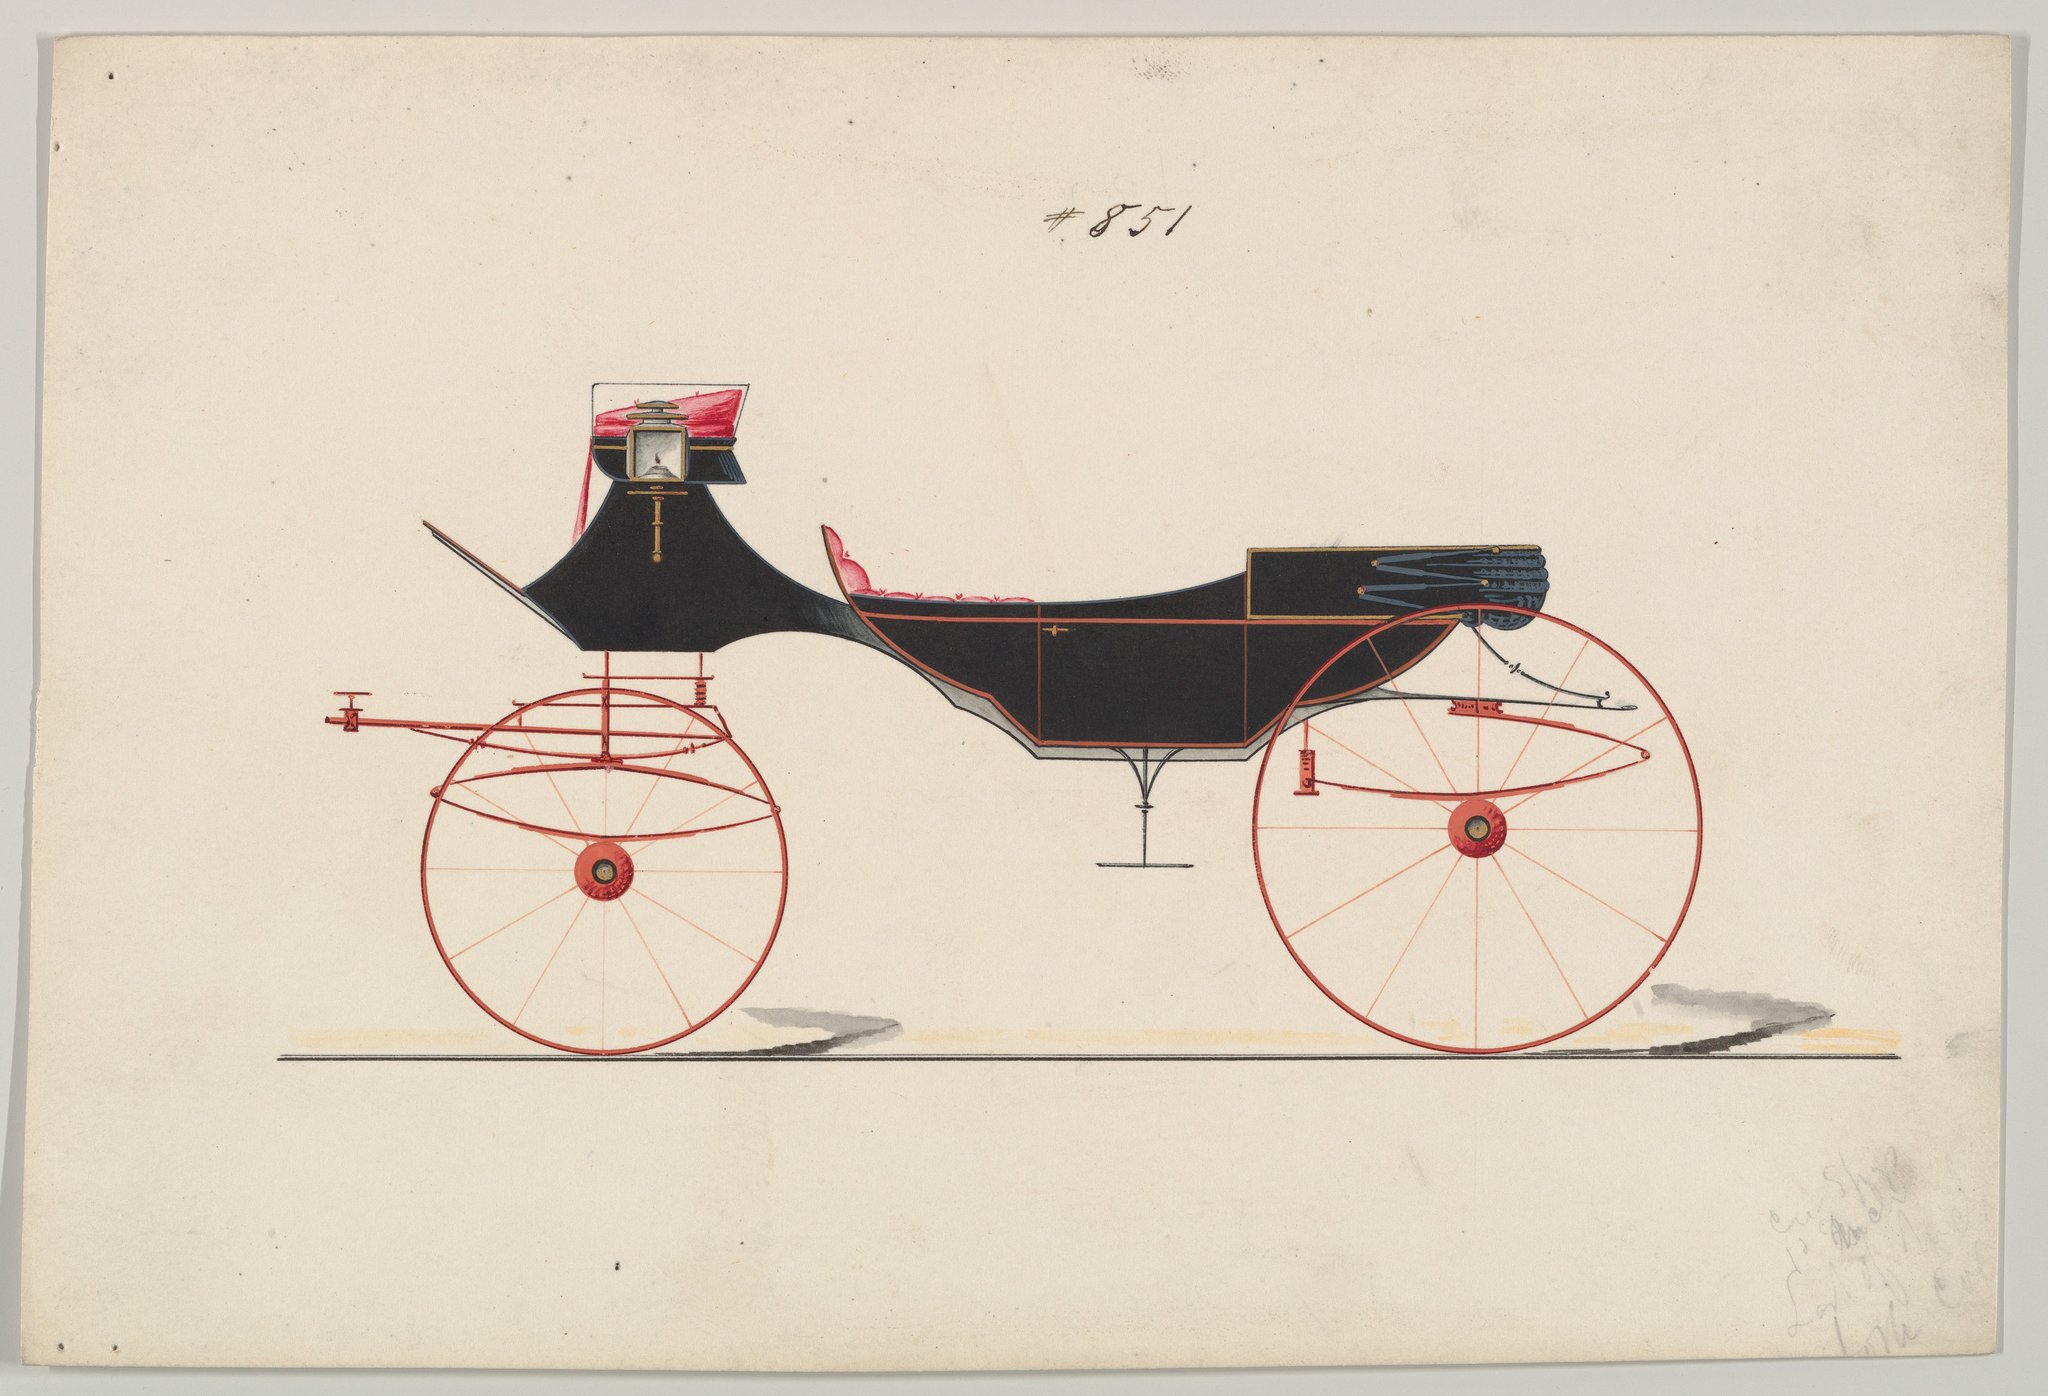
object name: drawing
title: Design for Vis-à-vis/ Caleche, no. 851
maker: brewster & co.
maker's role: manufacturer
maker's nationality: american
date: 1850-1870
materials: gouache, graphite, ink, paint, watercolor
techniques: pen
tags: carriages